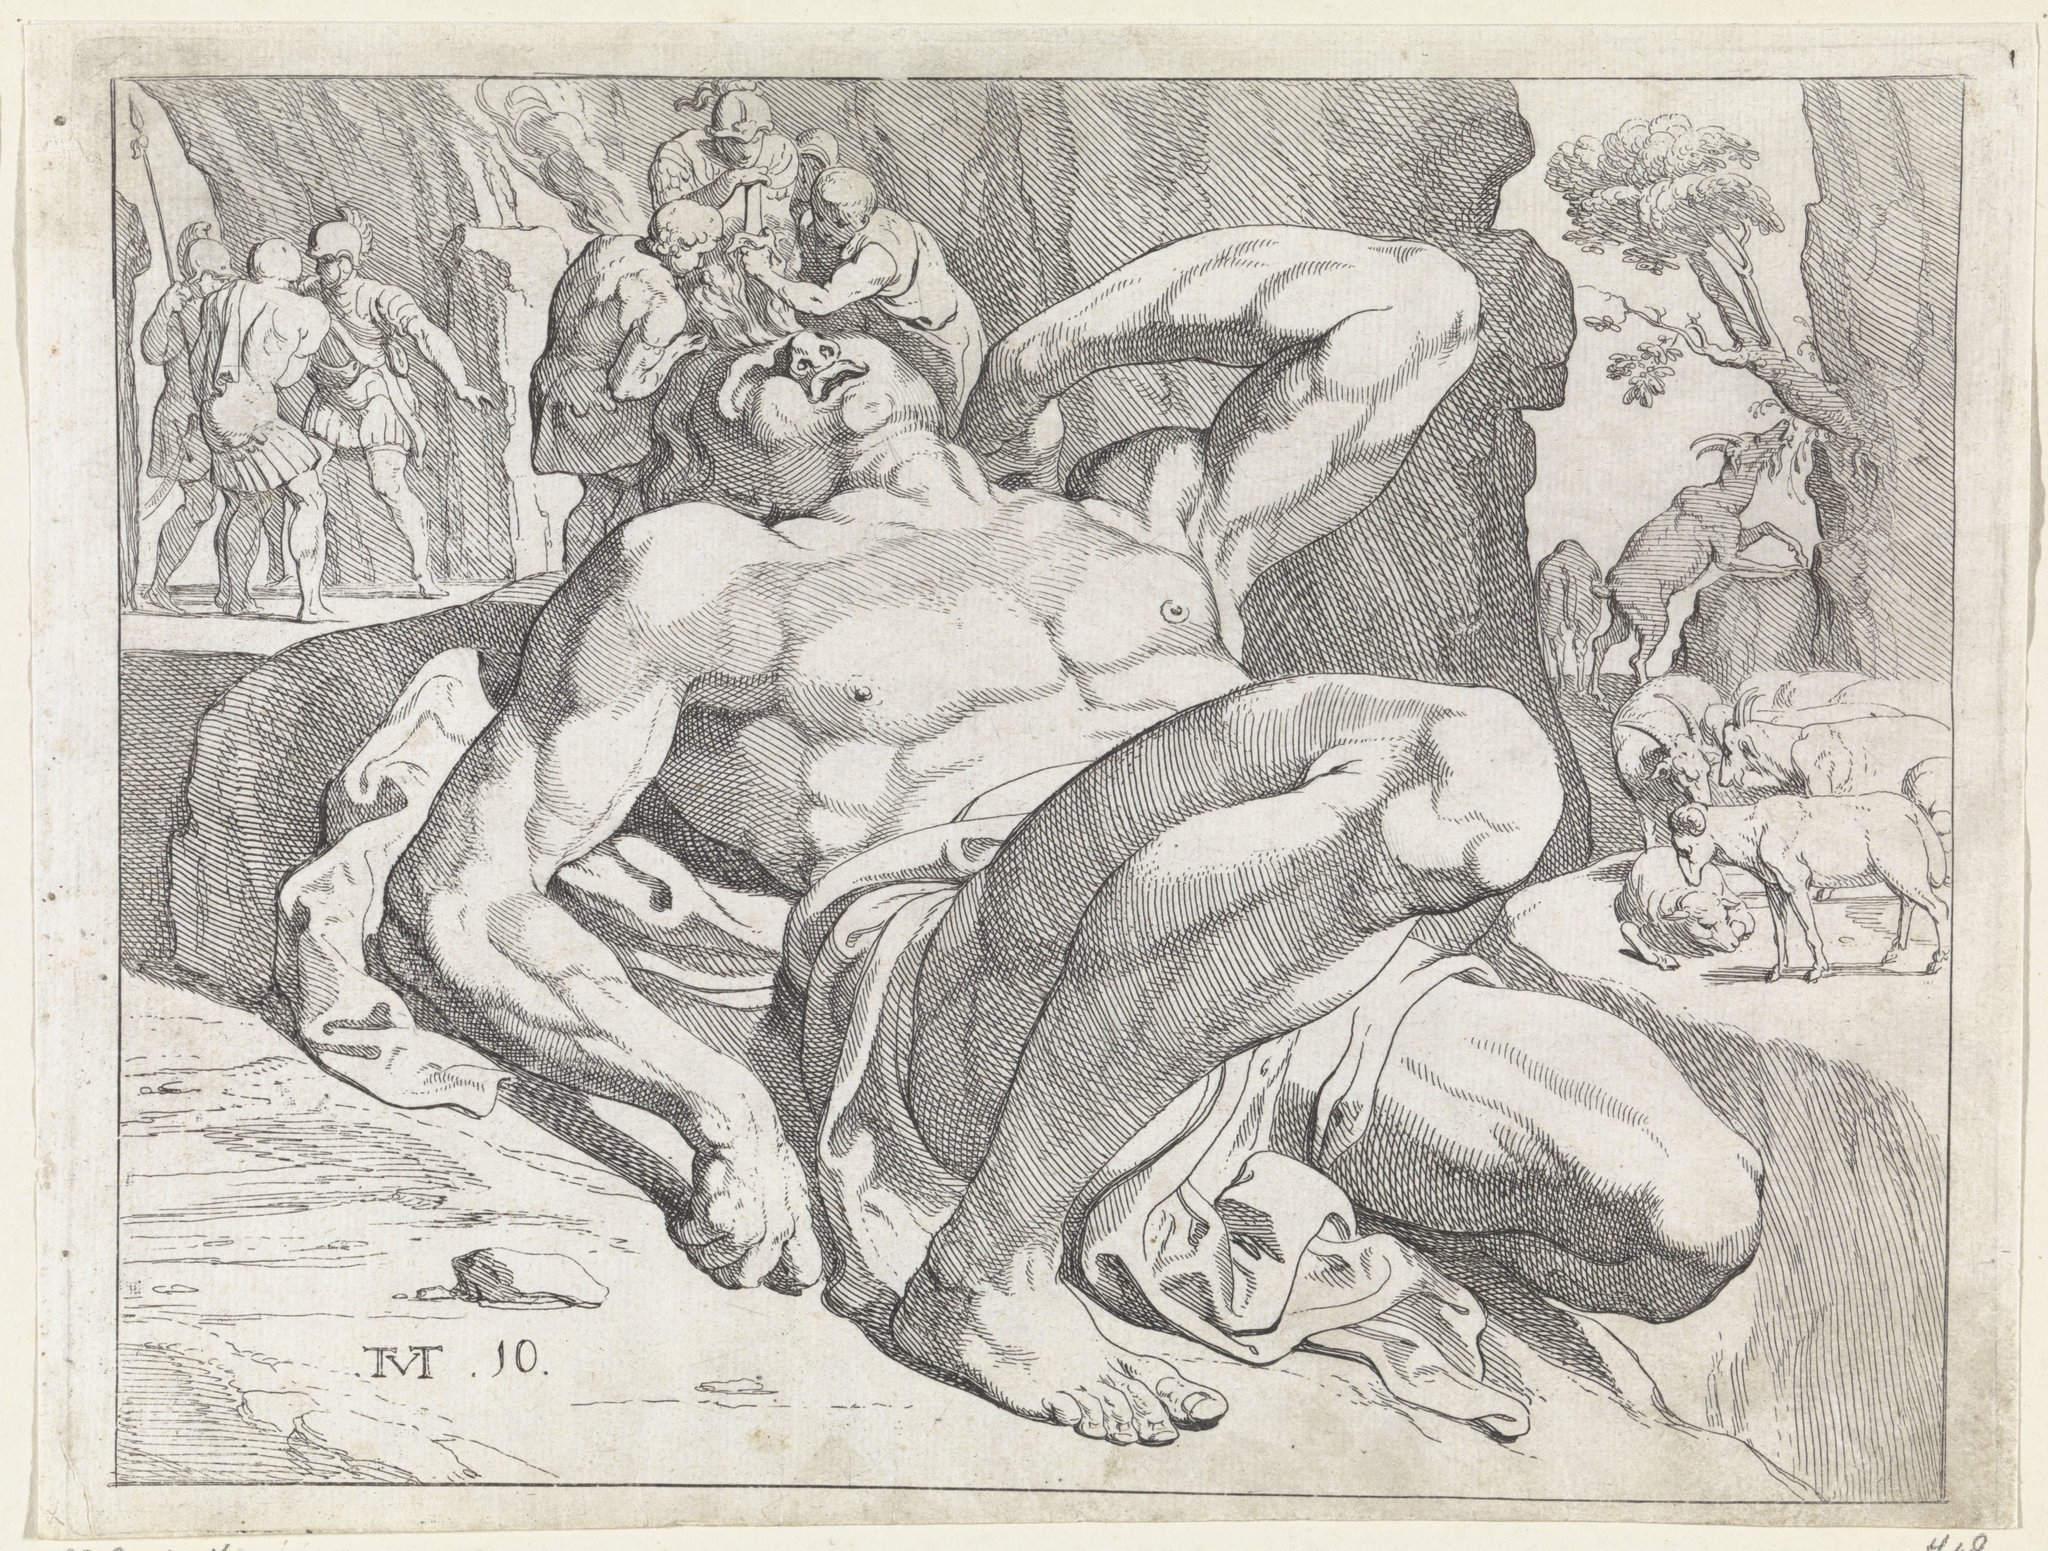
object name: print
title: De werken van Odysseus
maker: theodoor van thulden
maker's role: draughtsman, painter, print maker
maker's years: 1606-1669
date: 1632-1633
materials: paper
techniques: engraving, etching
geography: paris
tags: polyphemus is blinded with a pointed stake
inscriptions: collector's mark: Lugt 2228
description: Odysseus en zijn krijgslieden steken het oog van de reus Polyphemus uit.